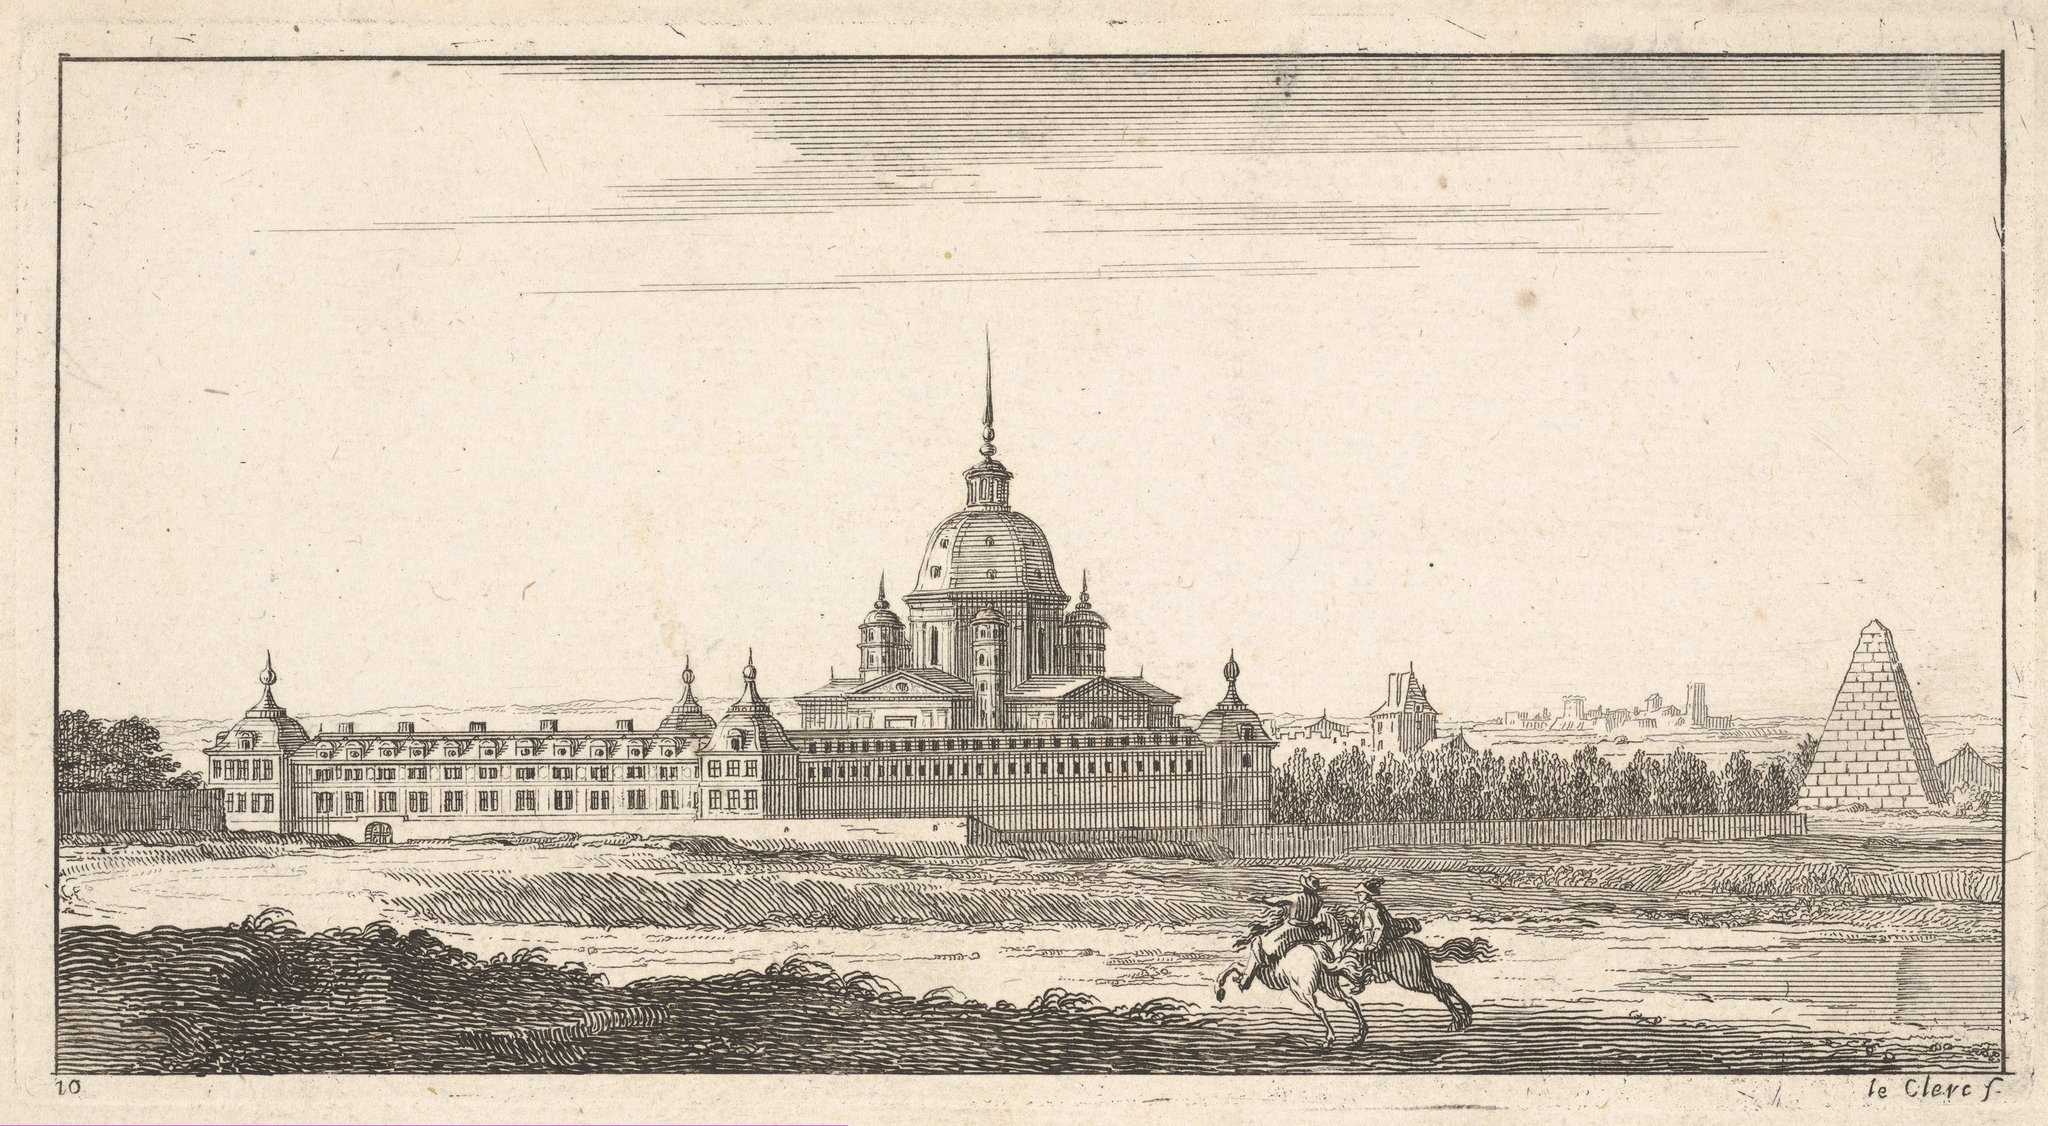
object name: print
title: View of a Town, plate X from "Livre de paysages dédié à Monsieur de Beringhen"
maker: sébastien leclerc (i)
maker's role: artist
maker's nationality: french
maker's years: 1637-1714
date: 1693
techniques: etching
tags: palaces,towns,horses